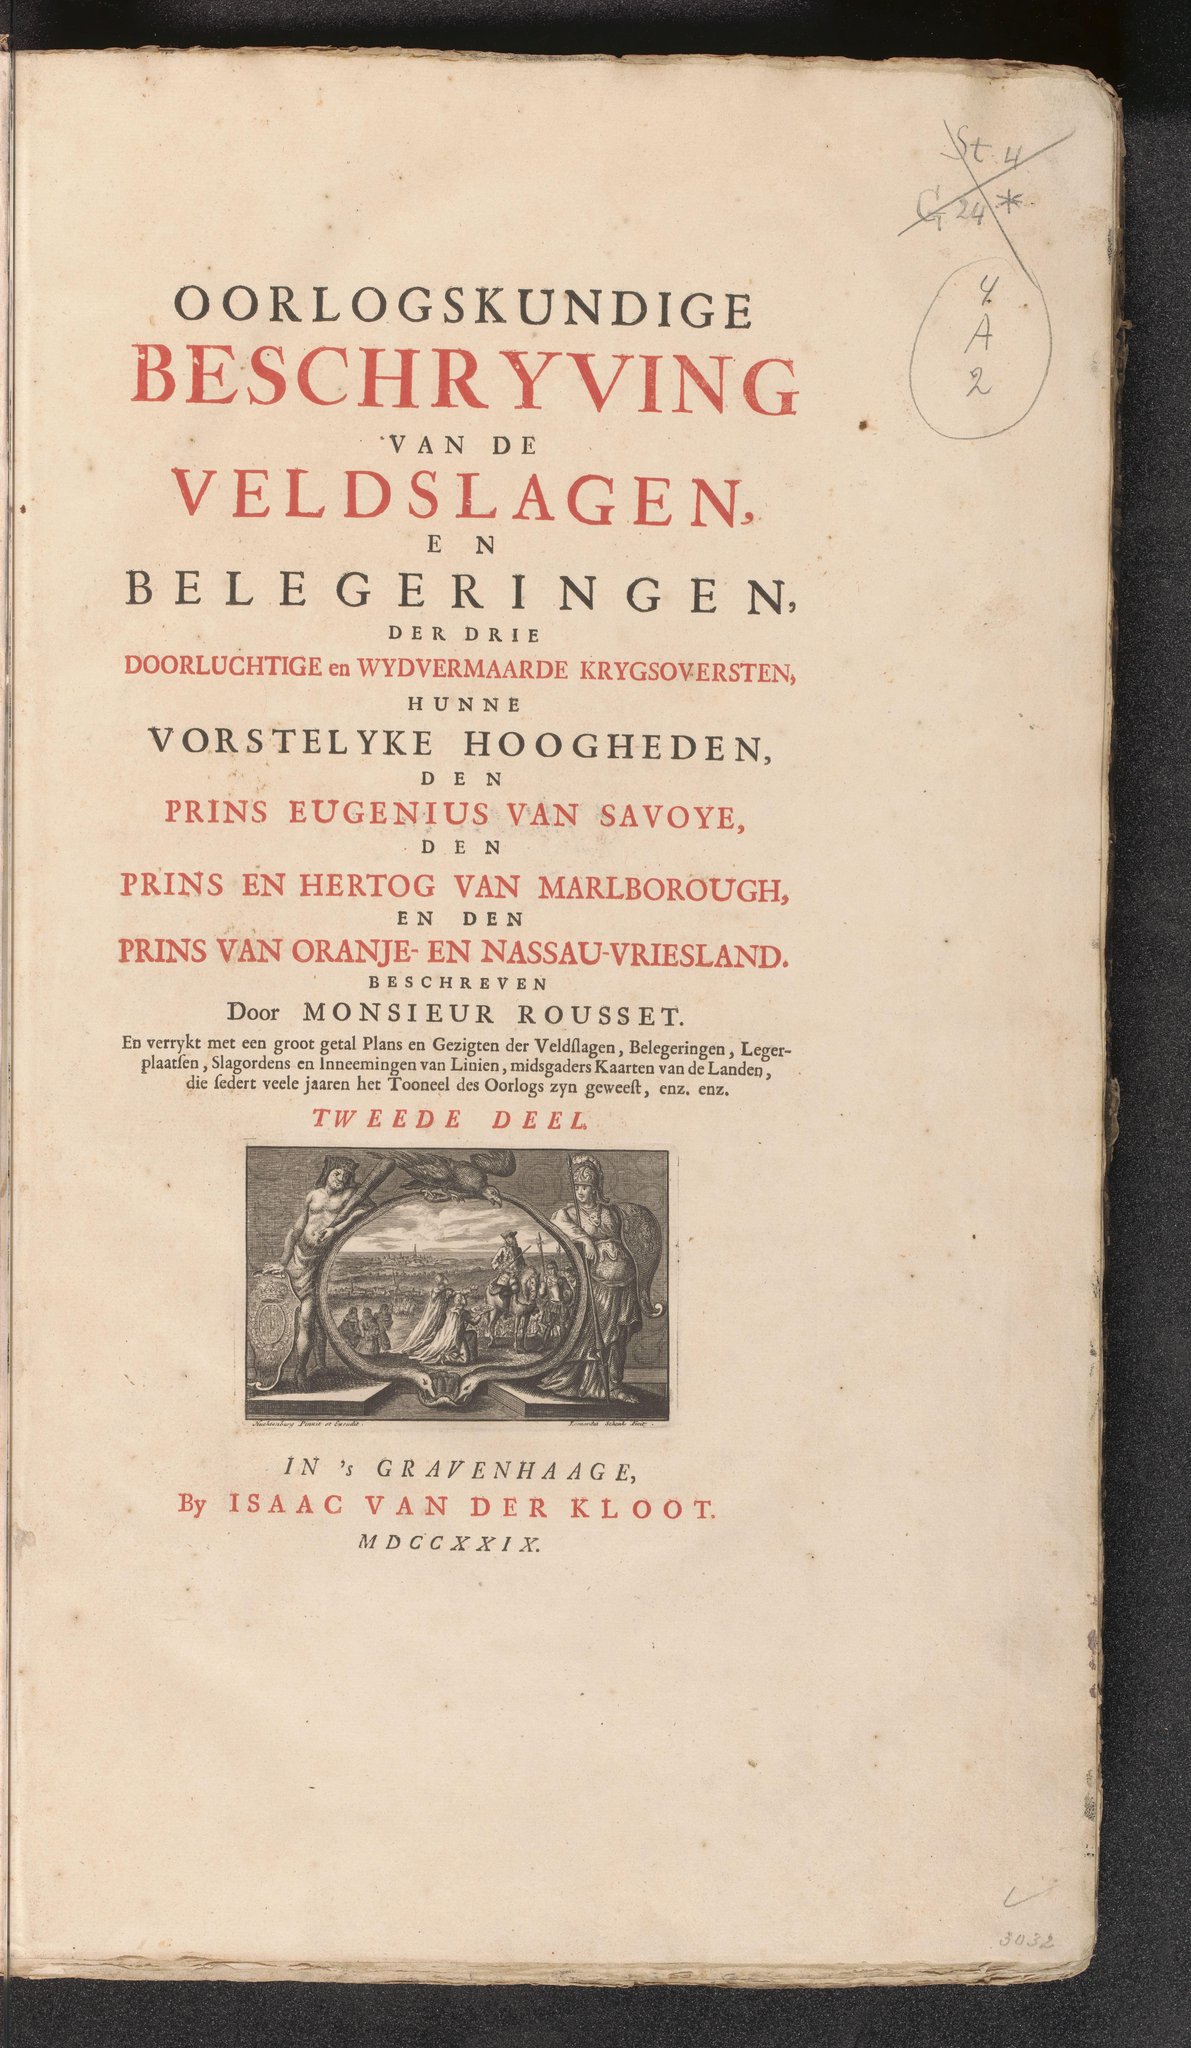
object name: titelblad, titelpagina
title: Titelpagina voor: [Jean] du Mont, Oorlogskundige beschryving van de veldslagen en belegeringen, der drie (...) wydvermaarde krygsoversten (...) den Prins Eugenius van Savoye, den (...) Hertog van Marlborough, en den Prins van Oranje en Nassau-Vriesland, Tweede Deel, 's-Gravenhage 1729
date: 1729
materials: paper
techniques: etching, letterpress printing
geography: the hague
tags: johan willem friso (prins van oranje-nassau), john churchill (1e hertog van marlborough), surrender of keys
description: Titelpagina voor: [Jean] du Mont, Oorlogskundige beschryving van de veldslagen en belegeringen, der drie ... wydvermaarde krygsoversten... den Prins Eugenius van Savoye, den ... Hertog van Marlborough, en den Prins van Oranje en Nassau-Vriesland, Tweede Deel, 's-Gravenhage 1729. Blad met de titel in boekdruk in rood en zwart met een vignet waarop een veldheer sleutels van een overwonnen stad aangeboden krijgt, in omlijsting van slangen, Hercules en Minerva. Dit tweede deel is hoofdzakelijk gewijd aan de daden van de hertog van Marlborough en prins Johan Willem Friso.